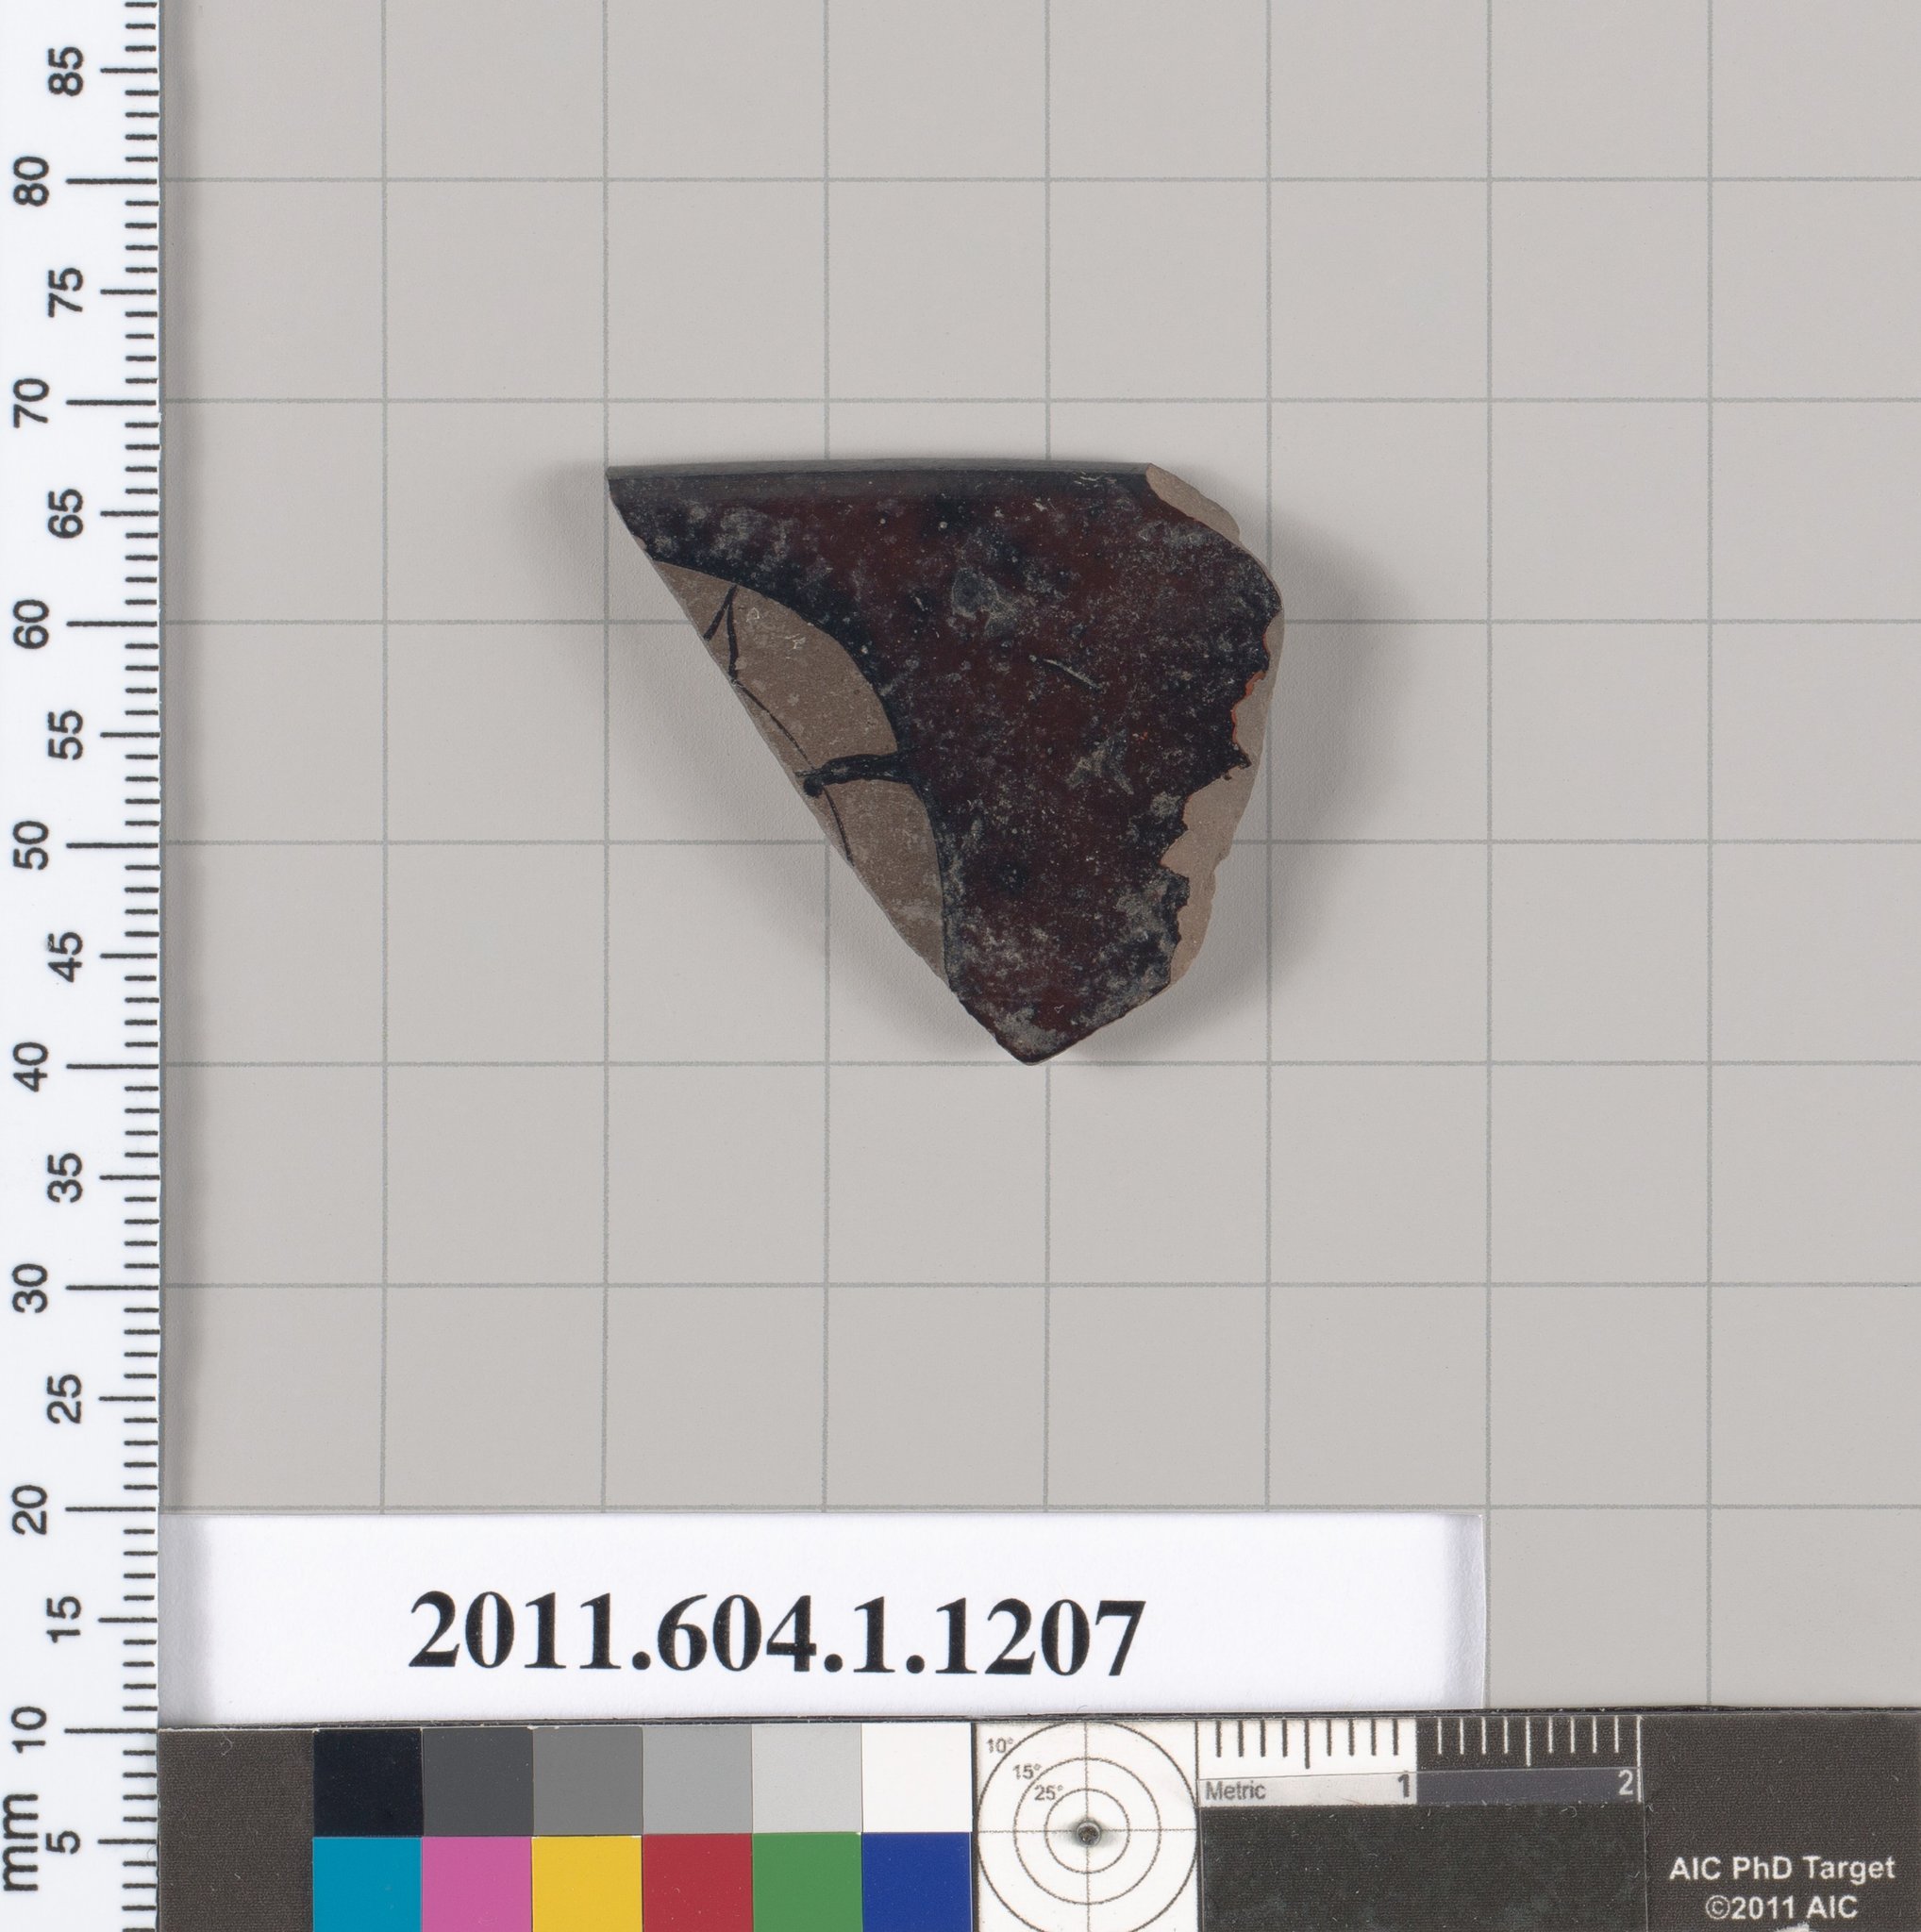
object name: kylix fragment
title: Terracotta rim fragment of a kylix (drinking cup)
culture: greek, attic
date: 490-480 BCE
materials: terracotta